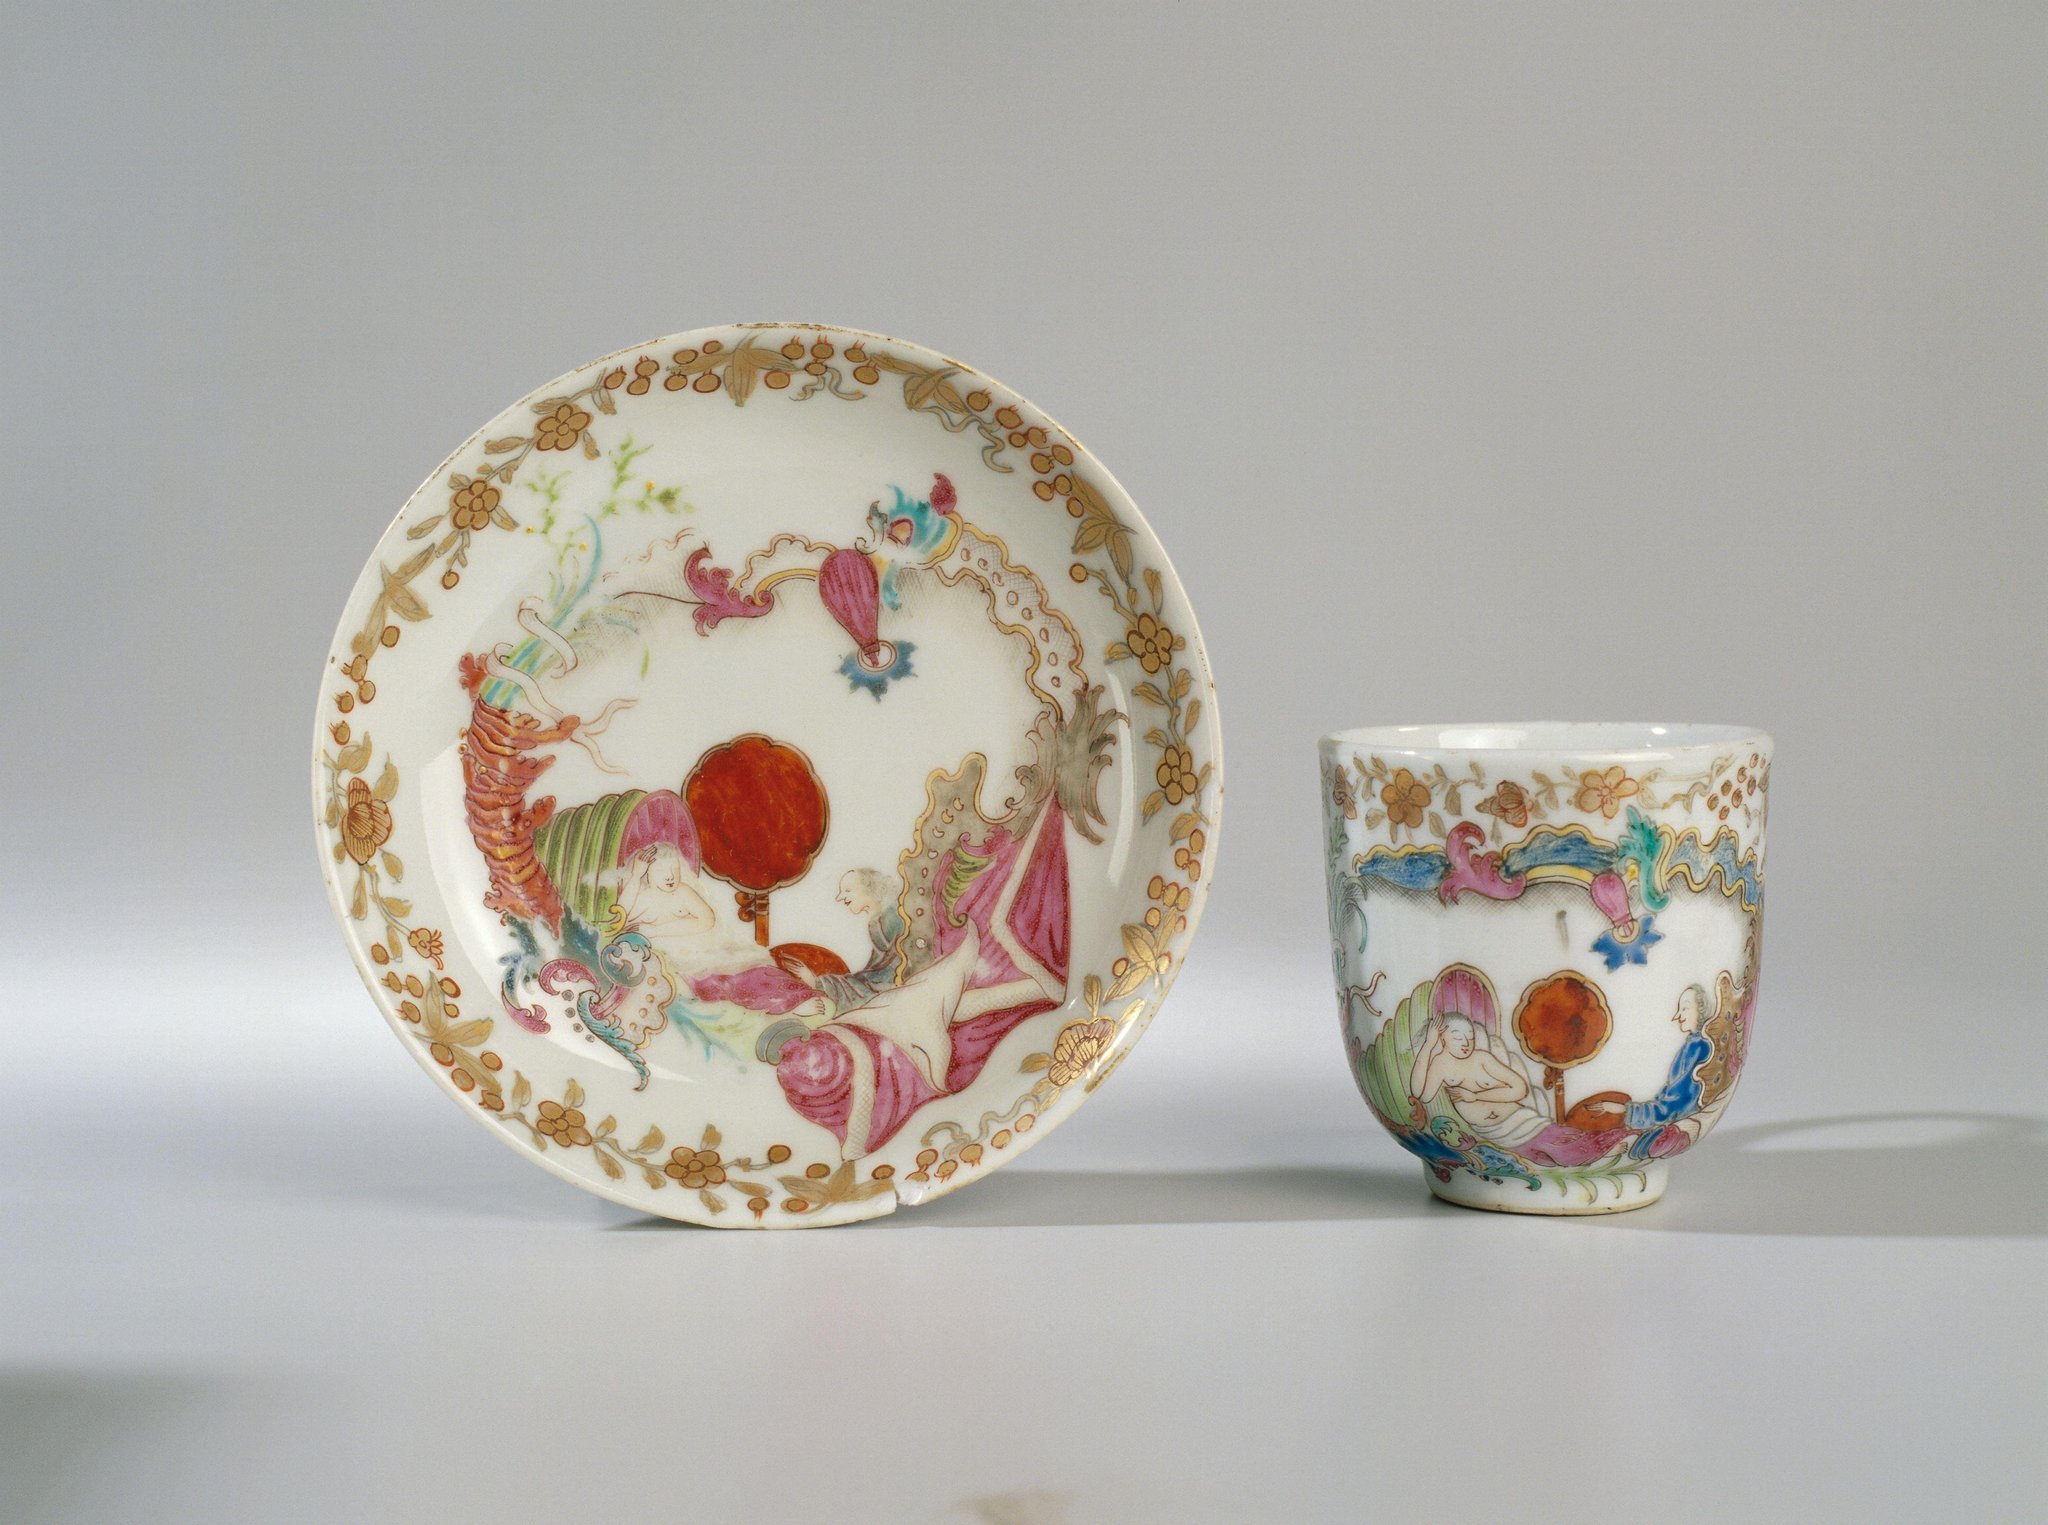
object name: platter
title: Saucer with an erotic scene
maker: Anonymous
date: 1745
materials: glaze, gold, paint, porcelain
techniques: firing, gilding, turning, vitrification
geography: china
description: Platte schotel op een voetring, gedecoreerd in emailkleuren. Zowel op de schotel als op de kop een voorstelling van een man en een half ontklede vrouw. Op het porselein is de letter A aangebracht. De randen van de kop en schotel zijn versierd met slingerende bloemtakken. Porselein met erotische scènes zoals deze vormen een aparte subgroep binnen het Deze kunnen variëren van zeer pornografisch tot milde erotische weergaven van klassieke mythologische liefdesverhalen. Mogelijk wijst de letter A erop dat dit porselein bestemd was voor een bepaalde persoon.